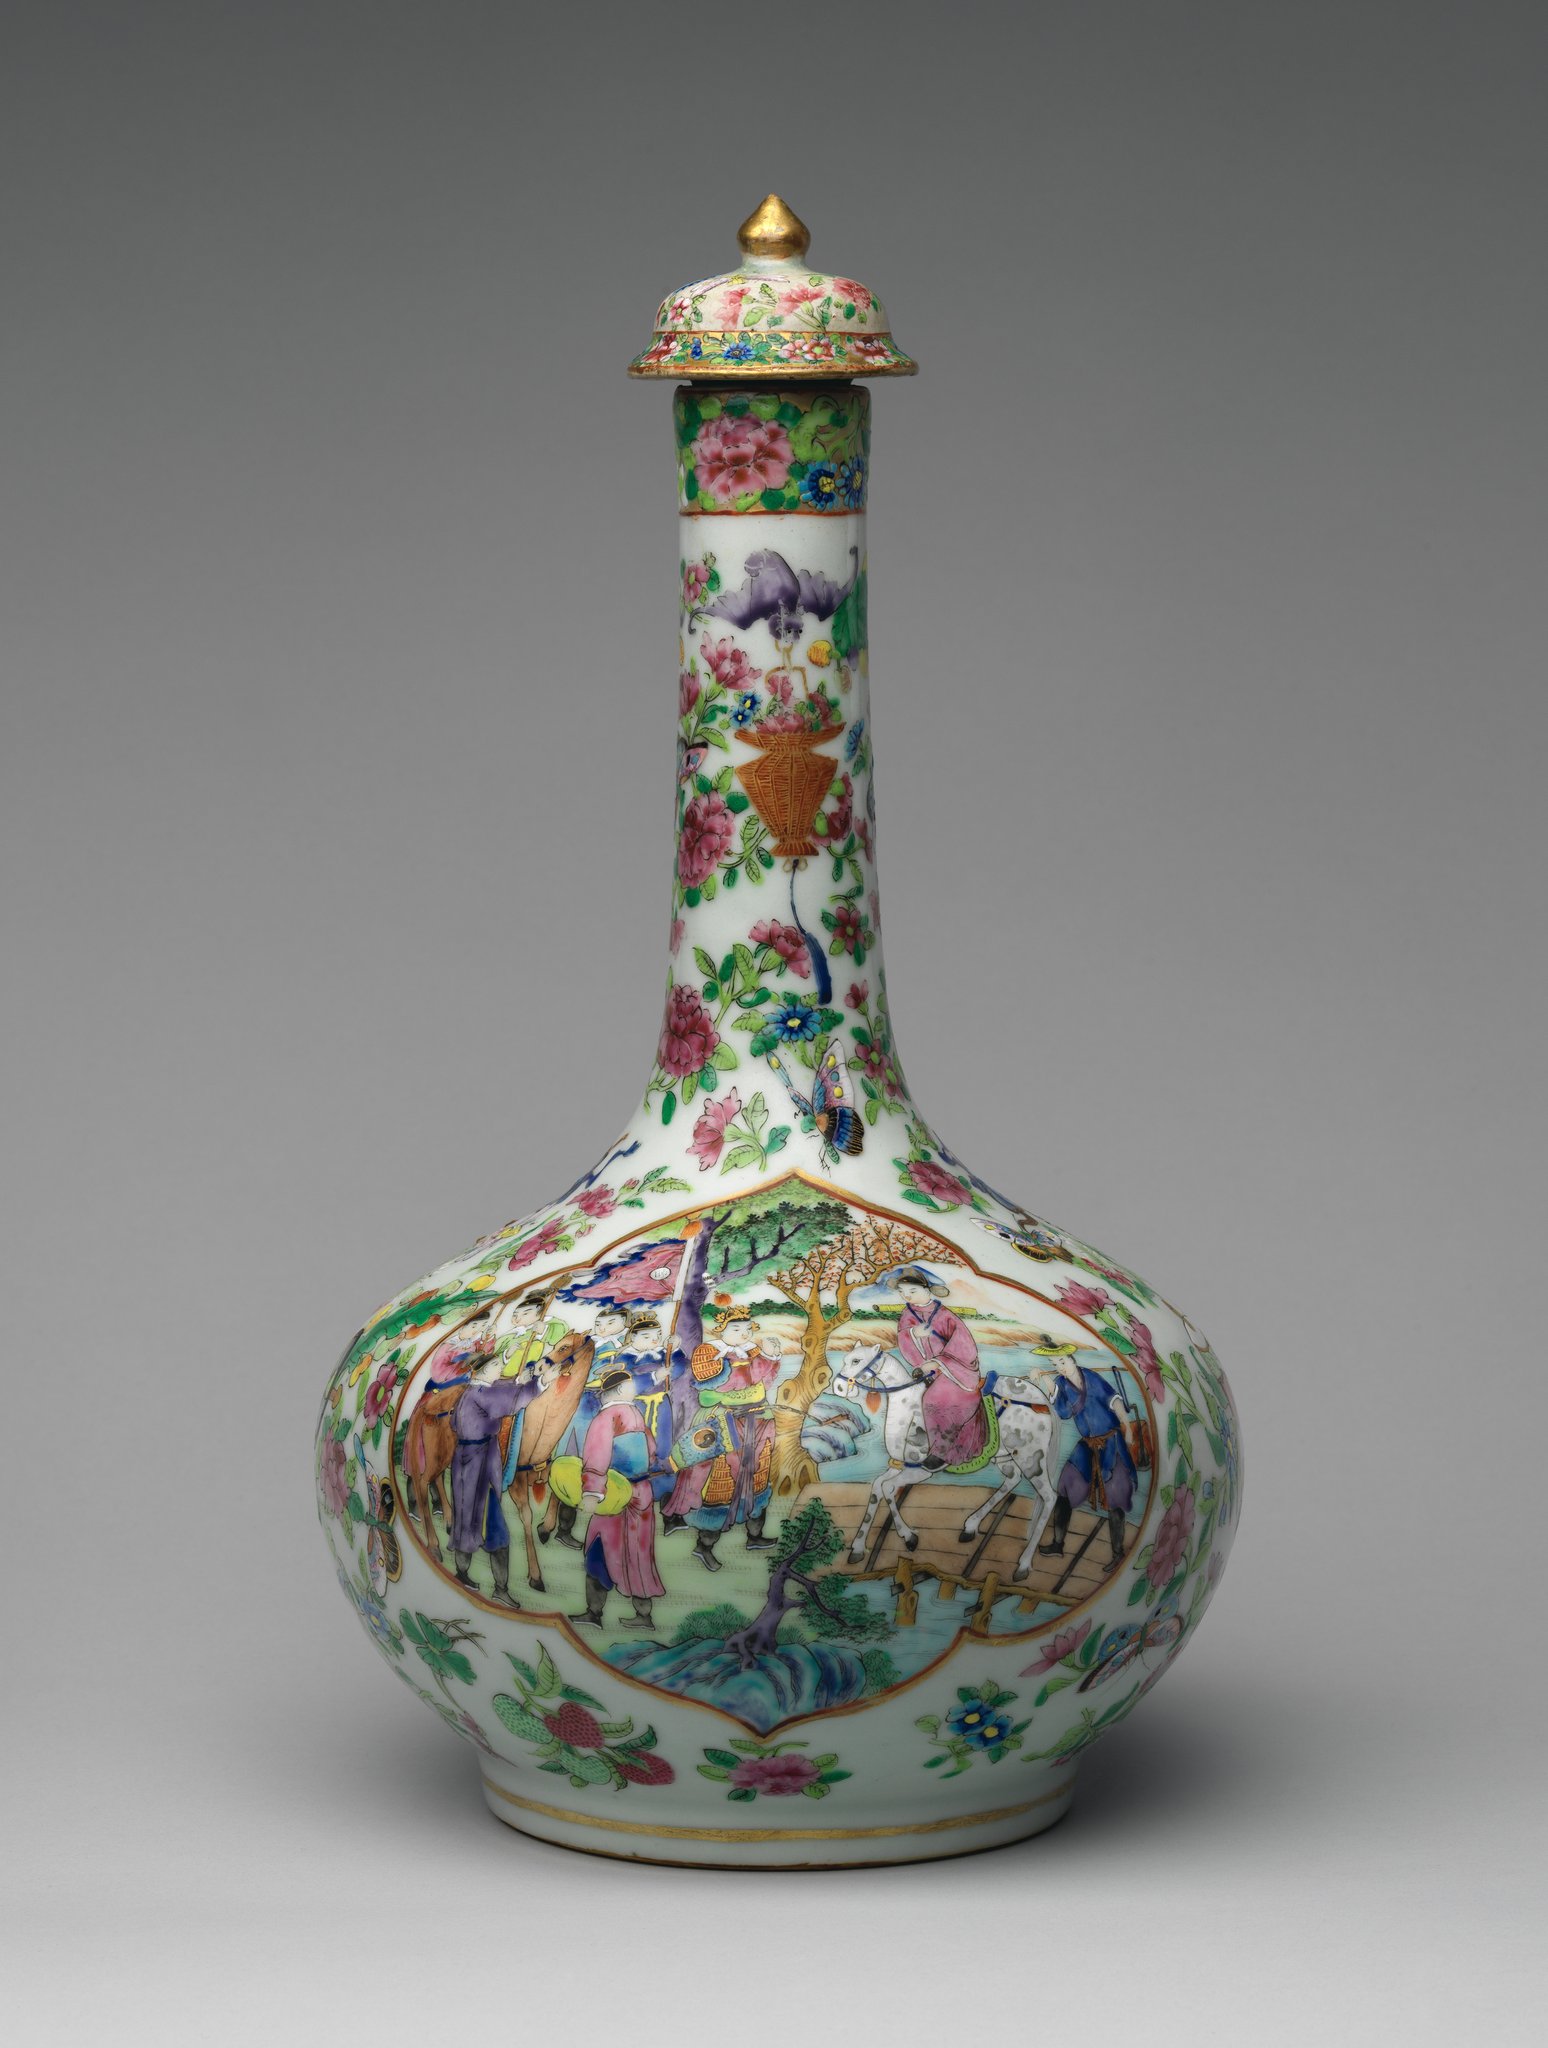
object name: bottle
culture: chinese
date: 1825-1845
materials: porcelain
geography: china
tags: men,women,horses,flowers,musicians